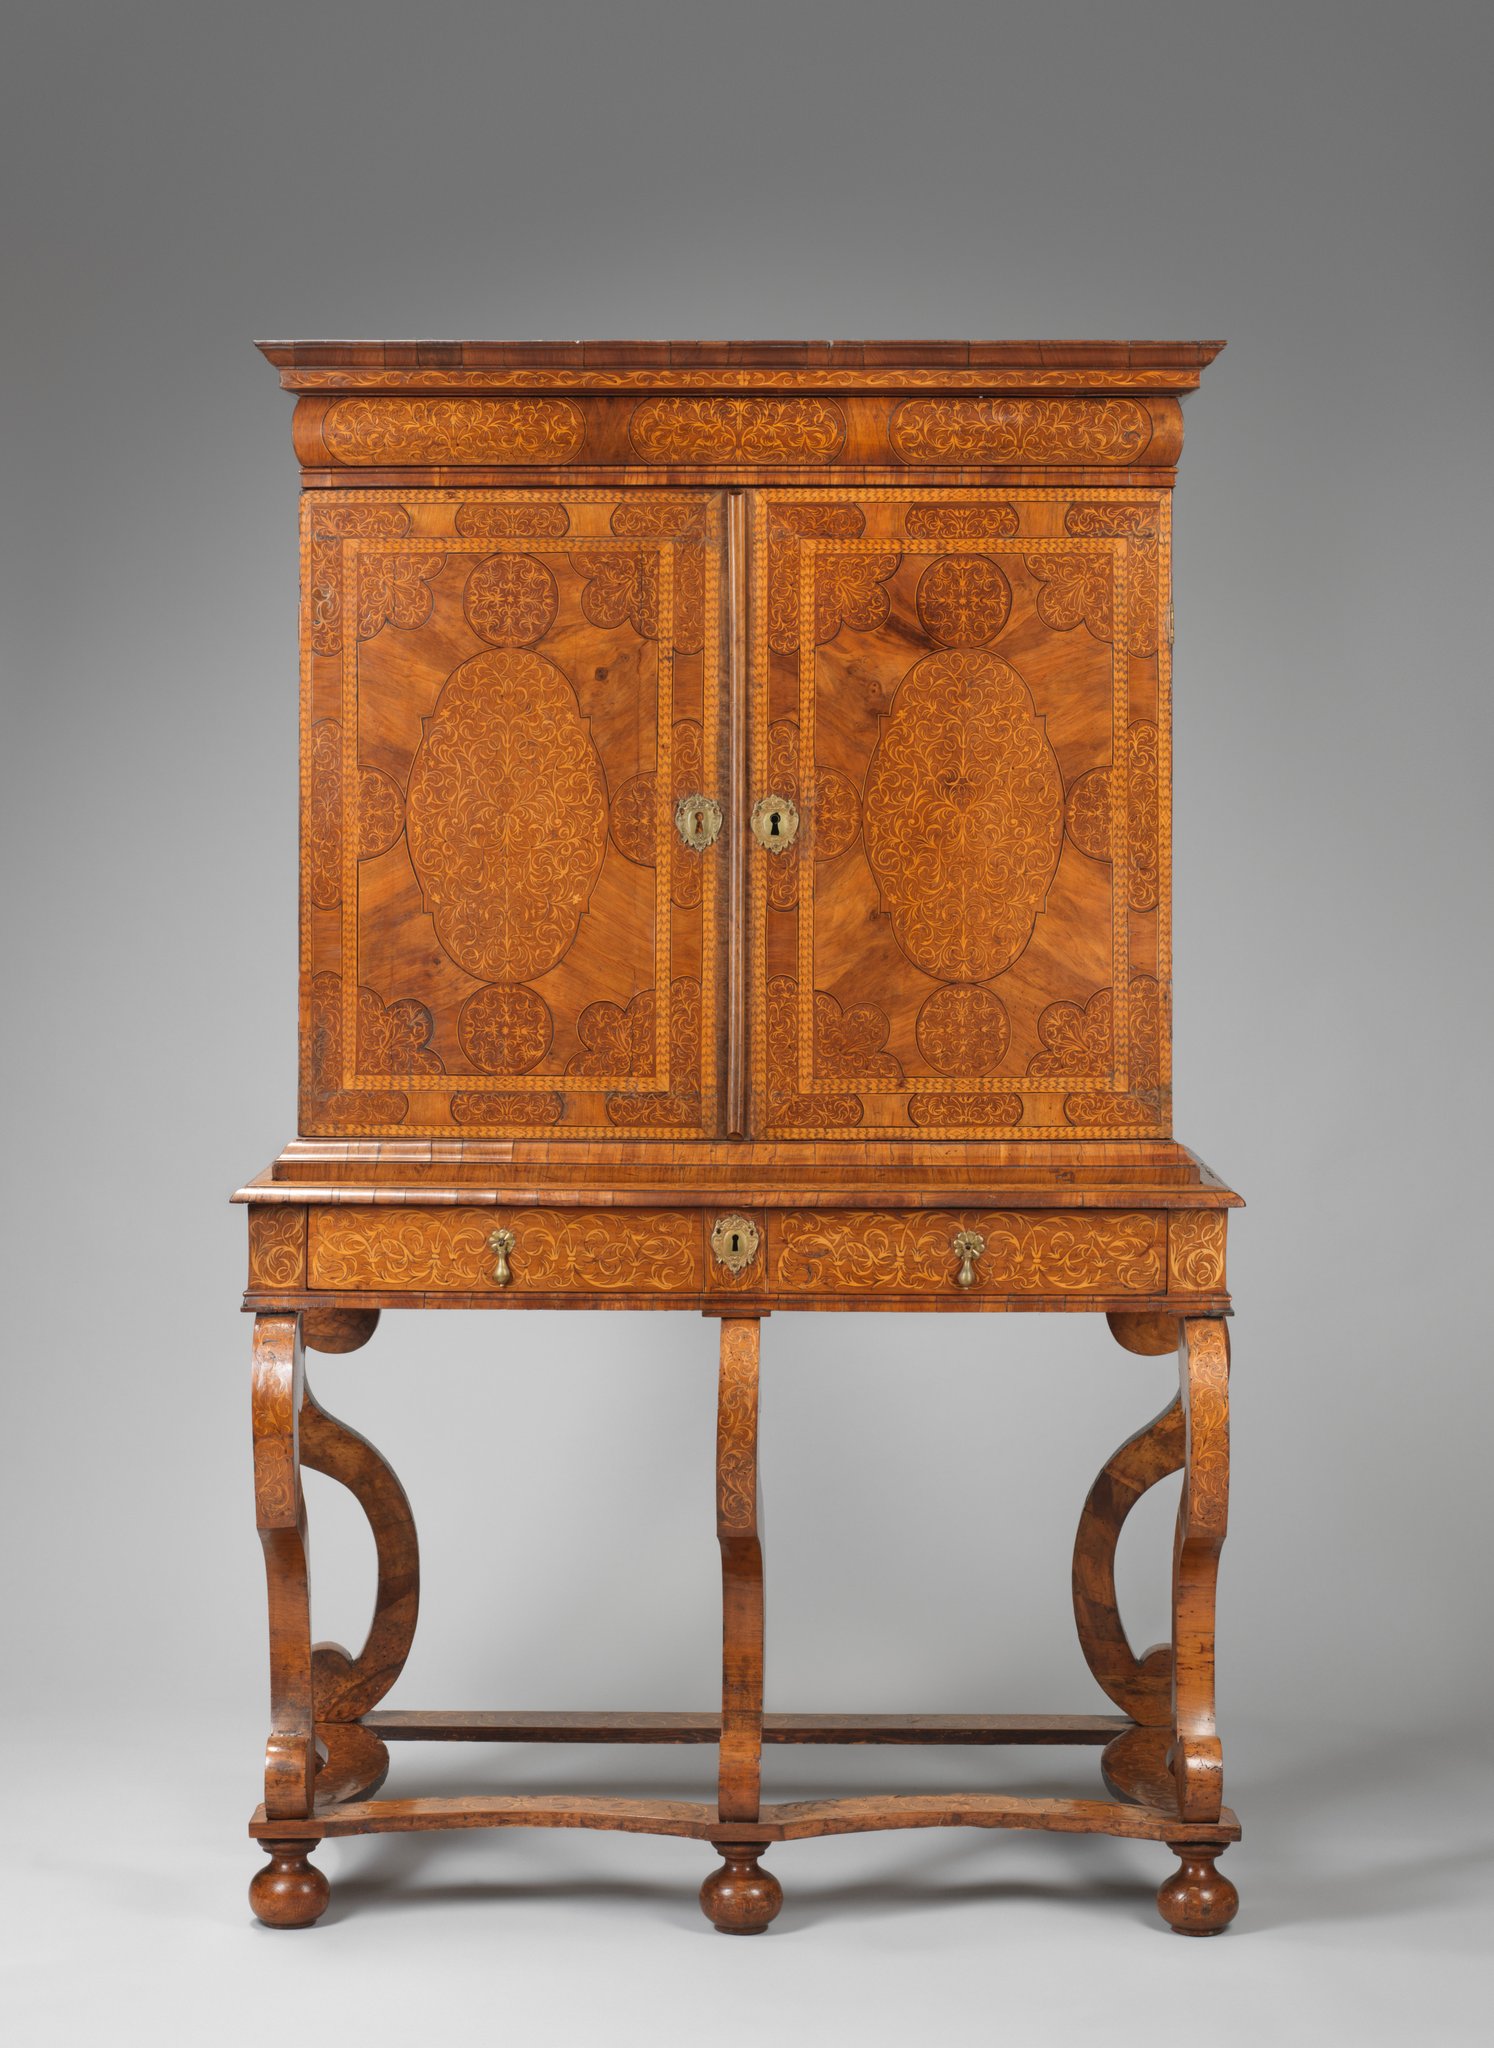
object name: acabinet on stand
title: Cabinet on stand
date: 1695-1700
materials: brass, wood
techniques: veneering